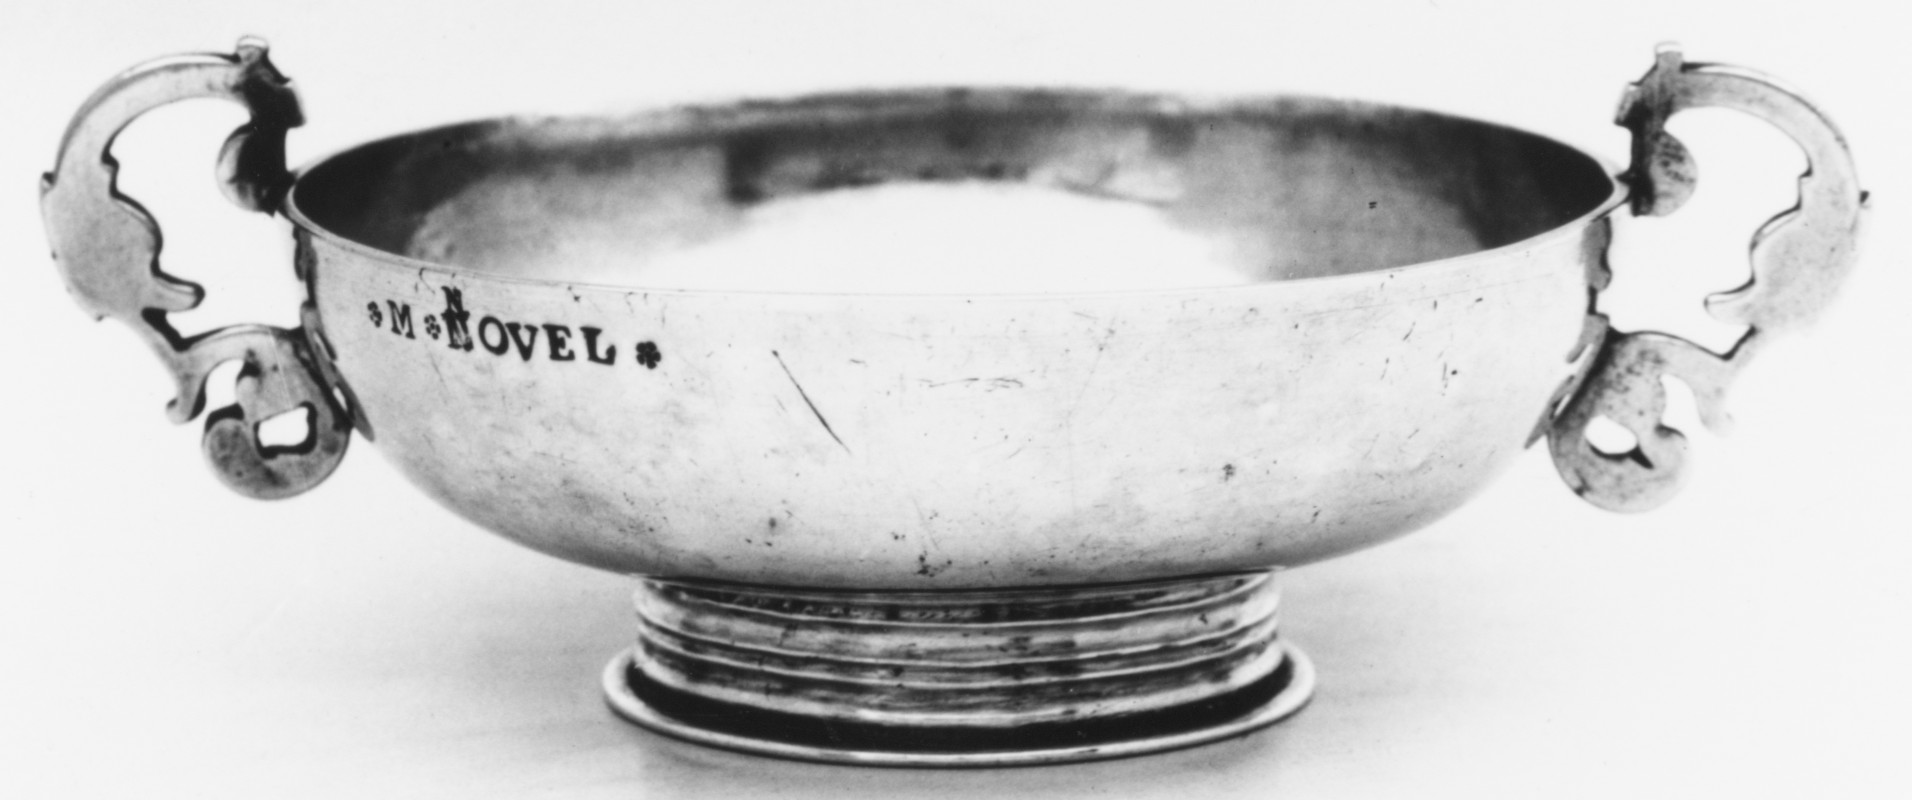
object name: collection cup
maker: guillaume le roy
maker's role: maker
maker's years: 1667-1729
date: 1702-1704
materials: silver